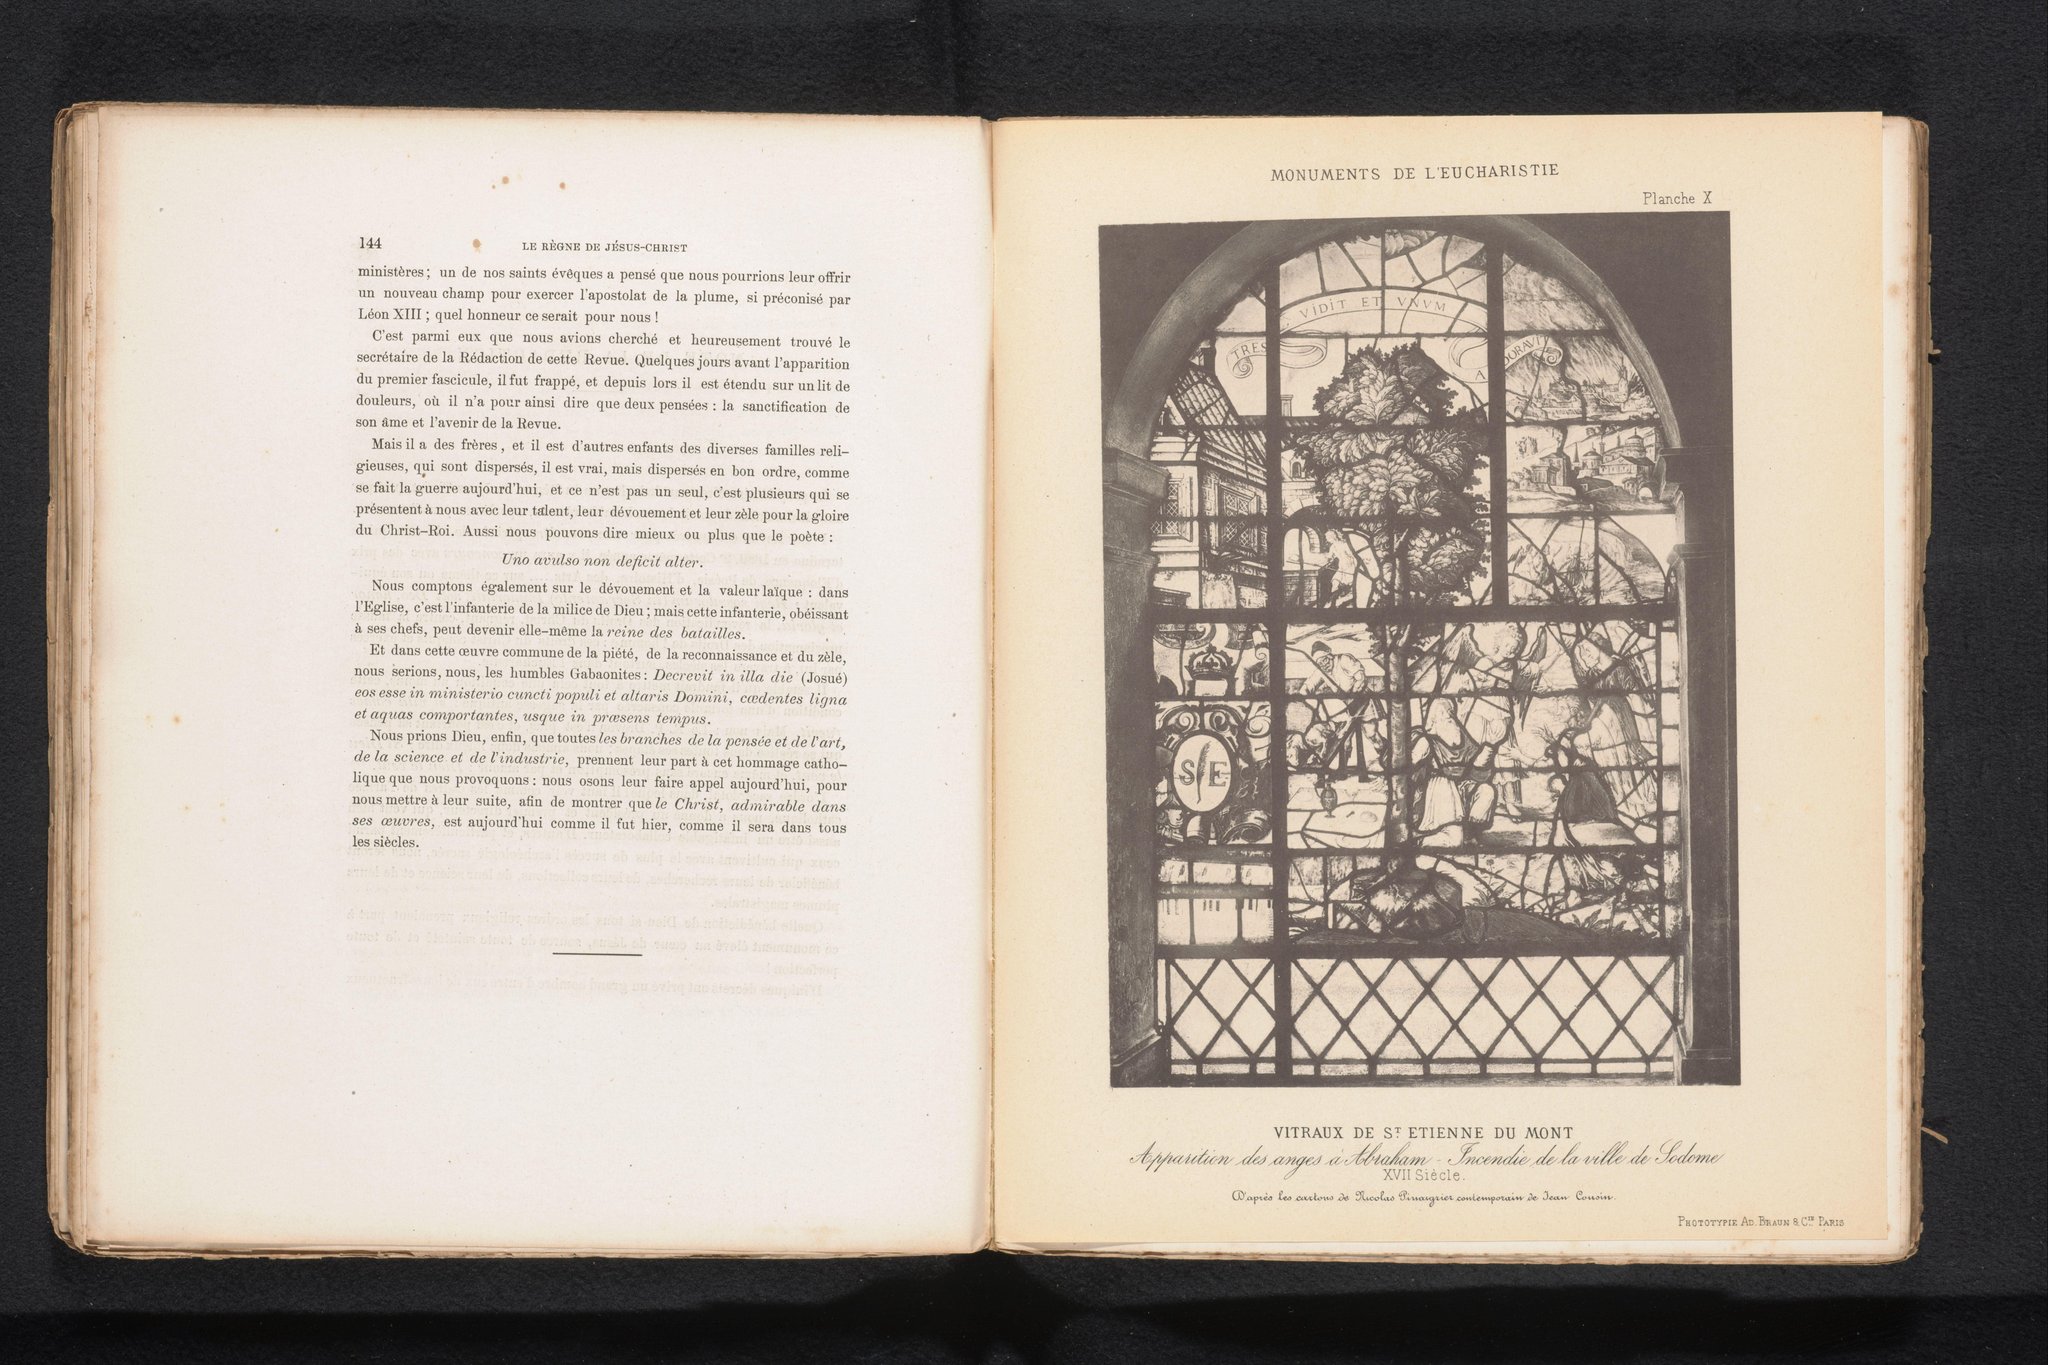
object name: photomechanical print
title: Monuments de l'Eucharistie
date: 1878-1883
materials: paper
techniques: photograph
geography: paris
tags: church-window, e.g. rose-window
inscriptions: inscription: ‘Apparition des anges à Abraham - Incendie de la ville de Sodome/ XVII Siècle./ D'après les cartons de Nicolas Pinaigrier contemporain de Jean Cousin.’, number: ‘Planche X’